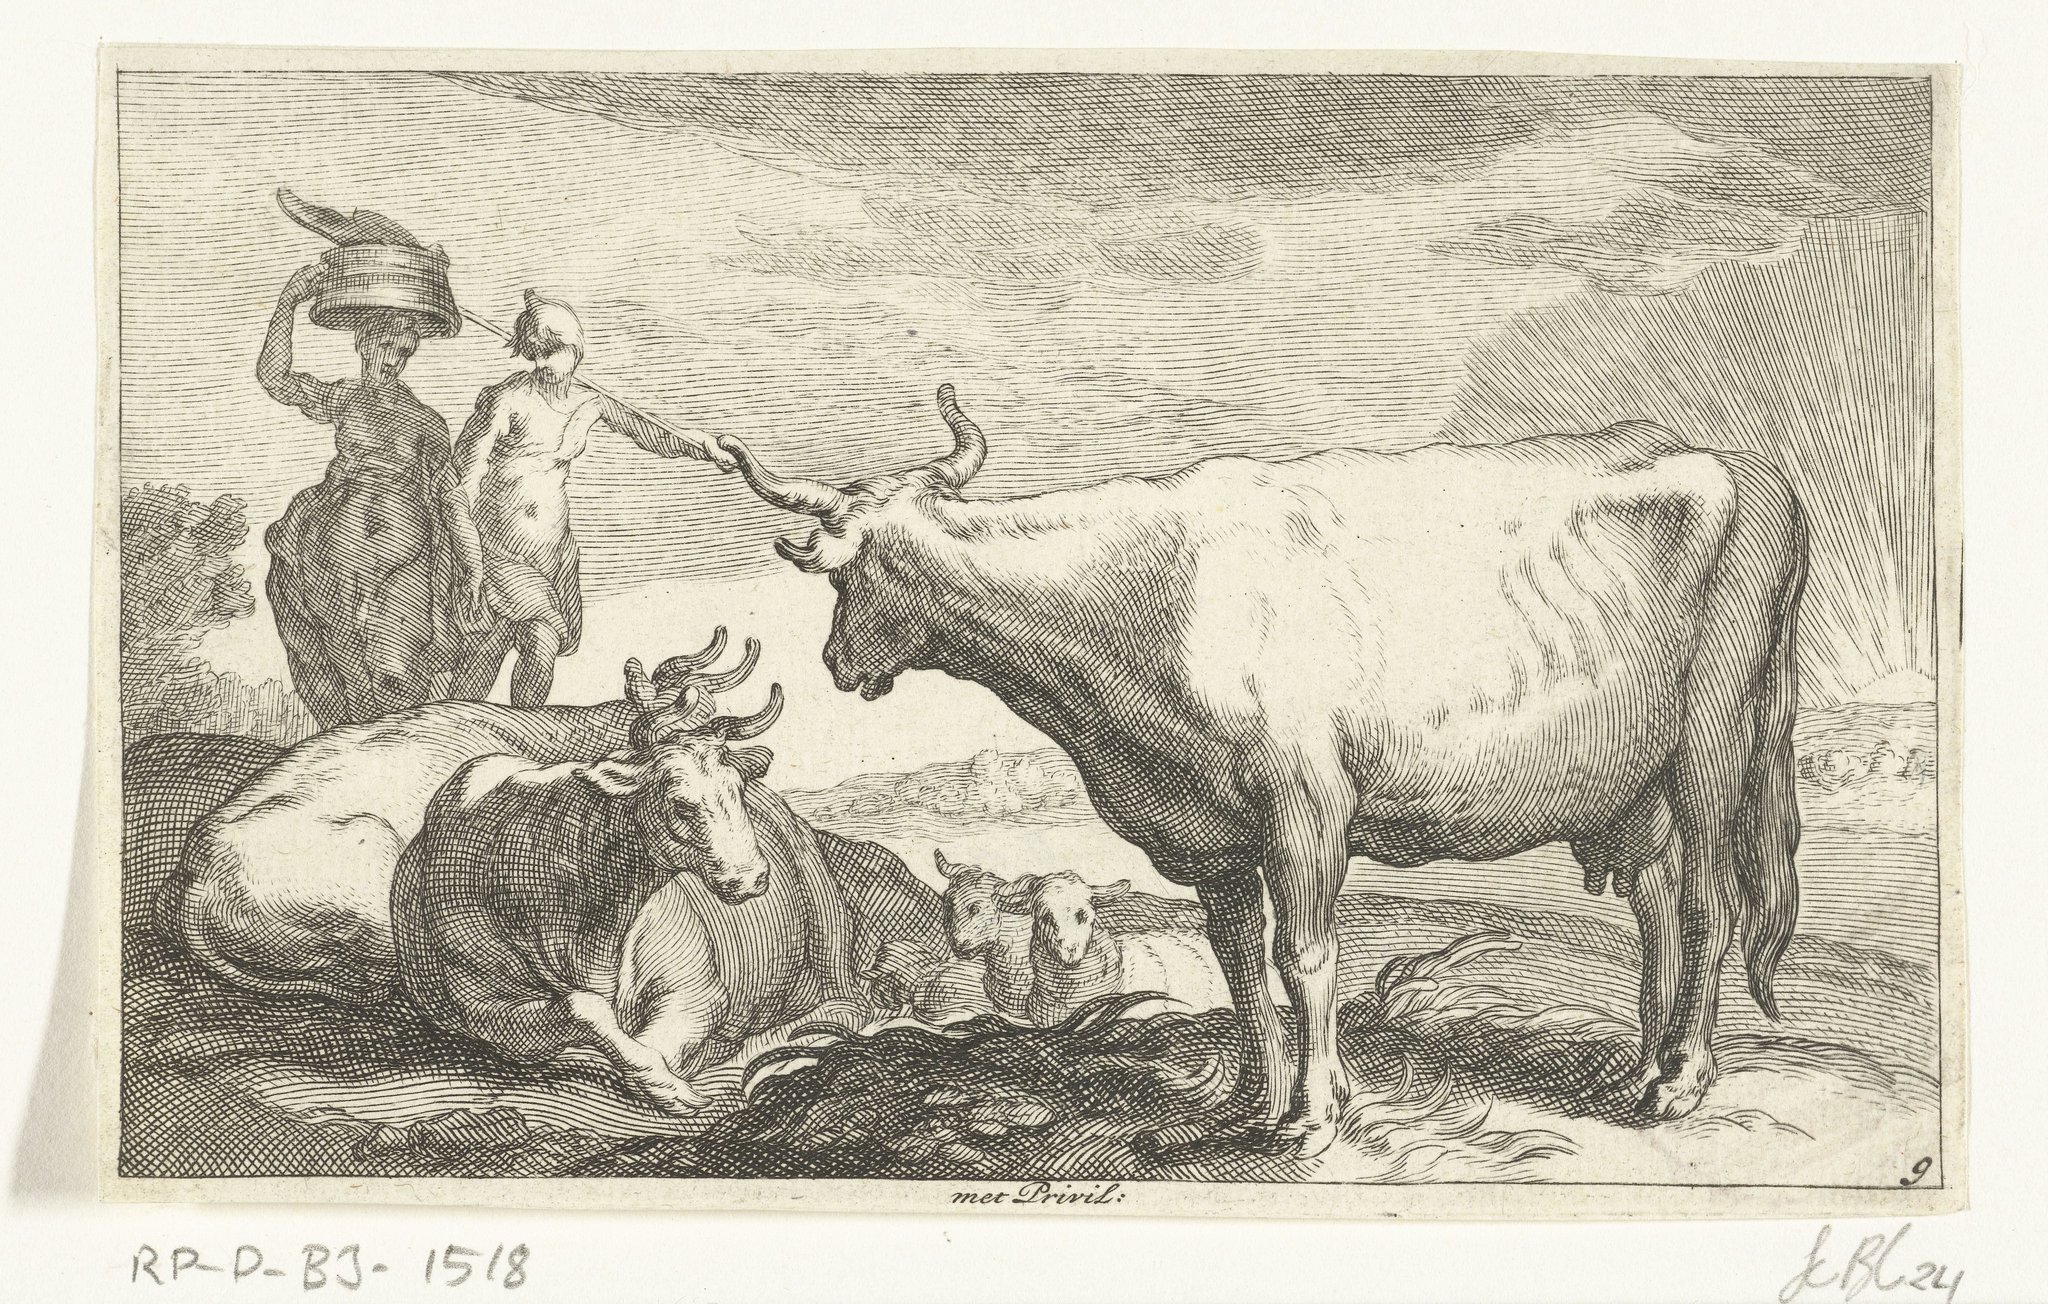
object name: print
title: Dieren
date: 1635-1670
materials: paper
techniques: engraving, etching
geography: utrecht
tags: cow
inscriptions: collector's mark: Lugt 240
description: Een kudde koeien met twee kalfjes. Achter de dieren lopen twee vrouwen. Prent uit een serie van 14 prenten met verschillende inheemse dieren.